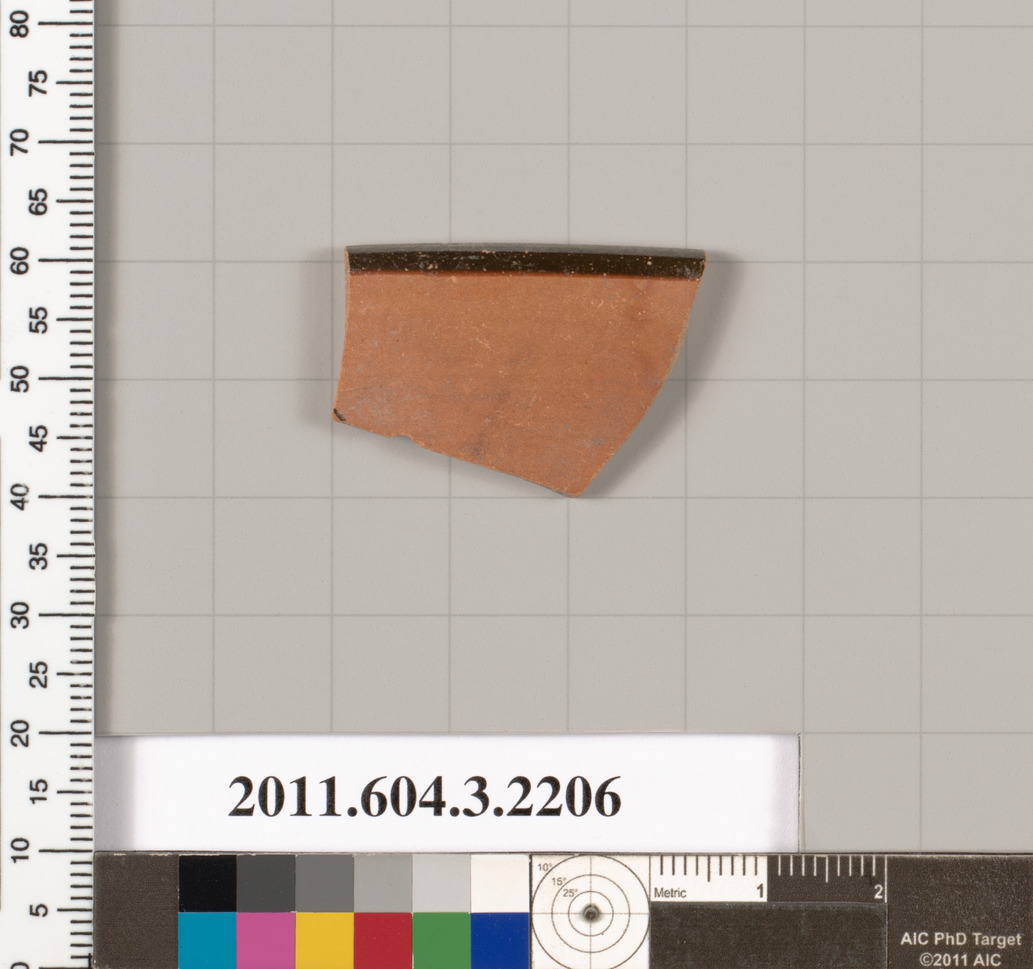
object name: kylix fragment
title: Terracotta fragment of a kylix (drinking cup)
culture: greek, attic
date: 600-401 BCE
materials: terracotta